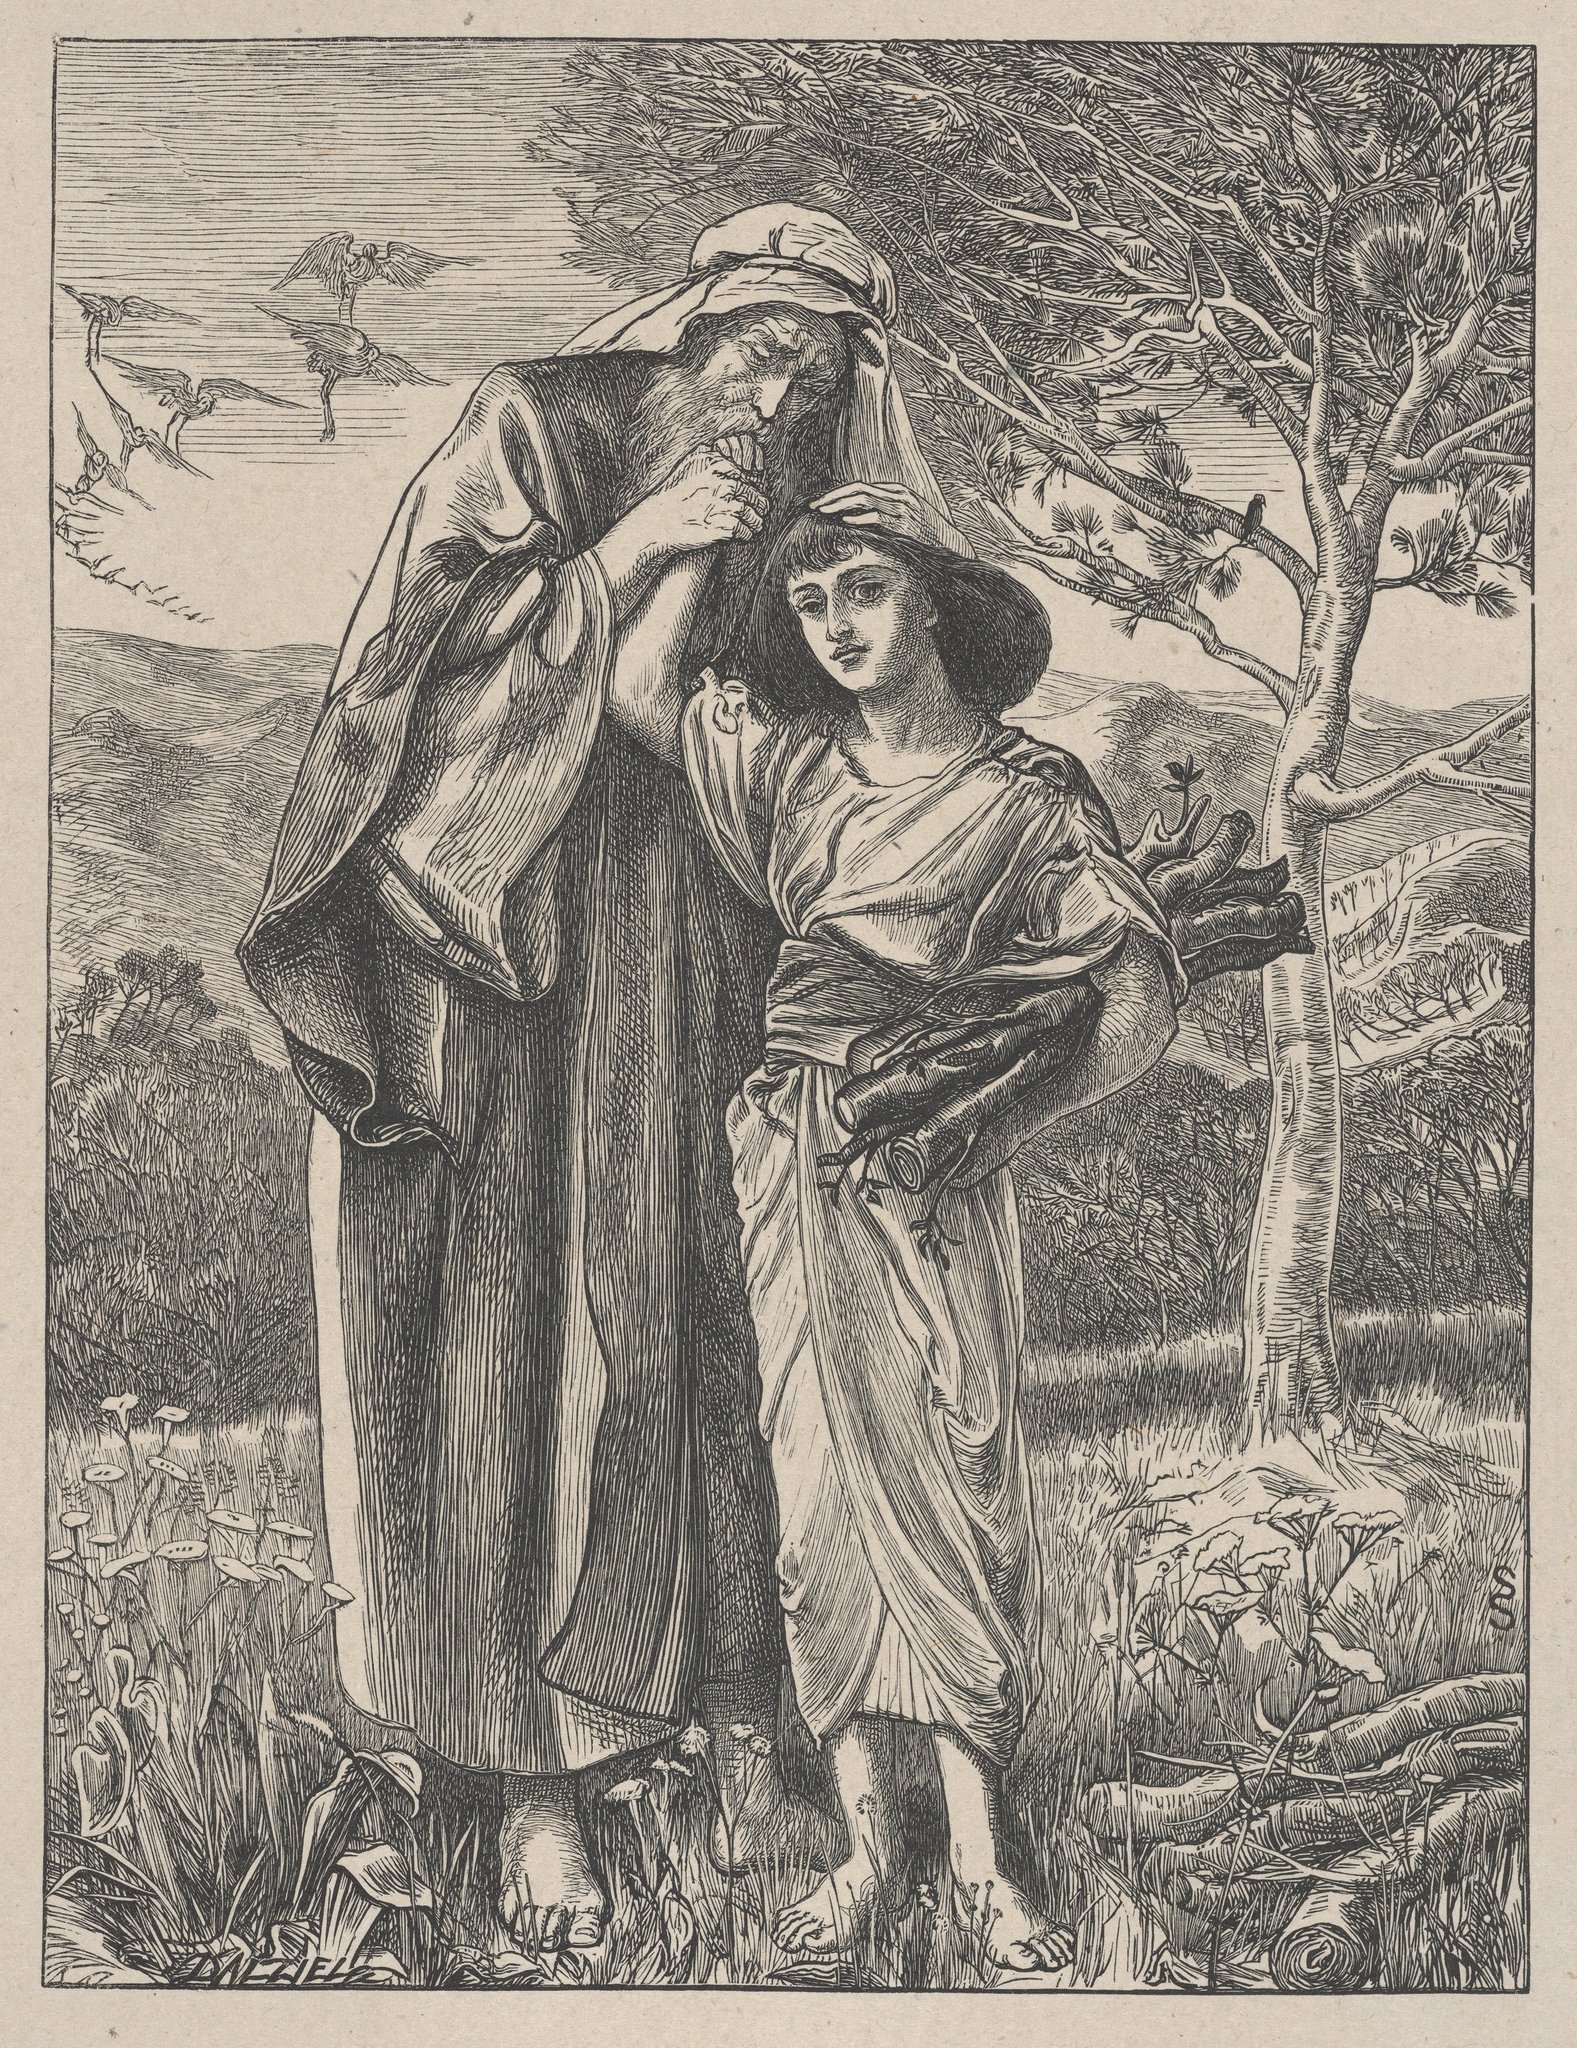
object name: print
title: Abraham and Isaac, from "Dalziels' Bible Gallery"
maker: simeon solomon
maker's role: artist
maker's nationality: british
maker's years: 1840-1905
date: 1863-1881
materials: paper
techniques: engraving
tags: boys,abraham